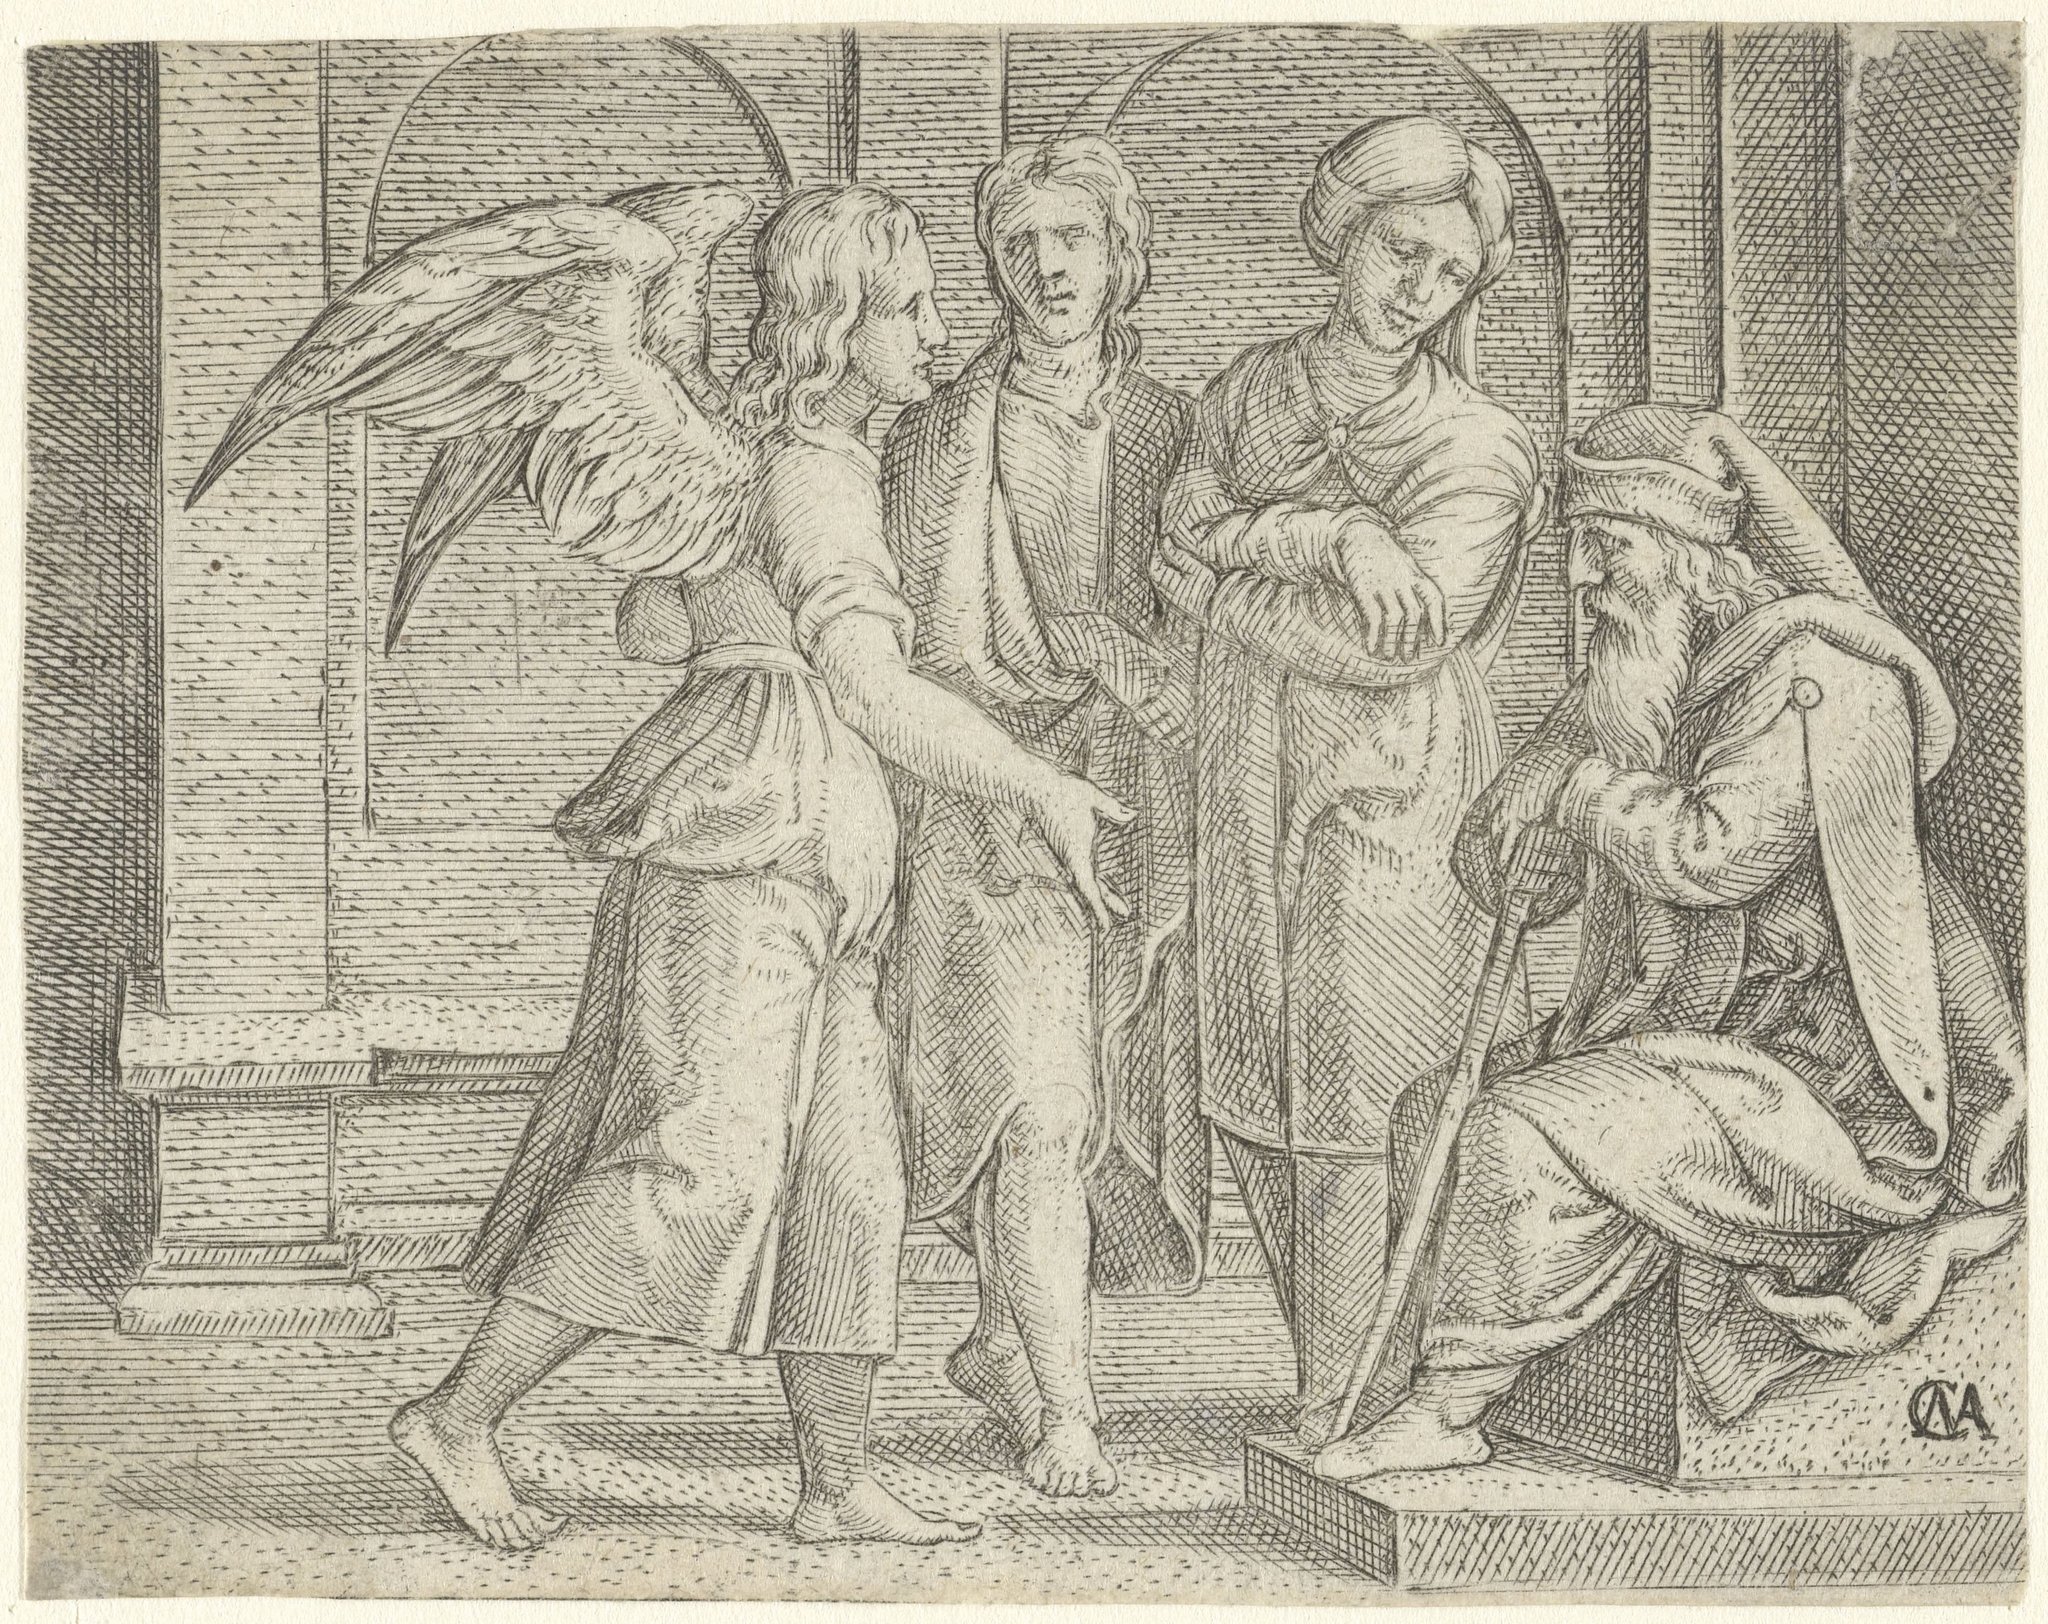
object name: print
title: Geschiedenis van Tobias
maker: cornelis massijs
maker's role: painter, print maker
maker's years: 1510-1557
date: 1544-1556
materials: paper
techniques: engraving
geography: antwerp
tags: tobias and the angel raphael with tobit (and anna)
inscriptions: collector's mark: Lugt 2228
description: De engel Rafaël stelt zich voor aan de zittende blinde Tobit. Tussen hen in staan Tobias en Anna.